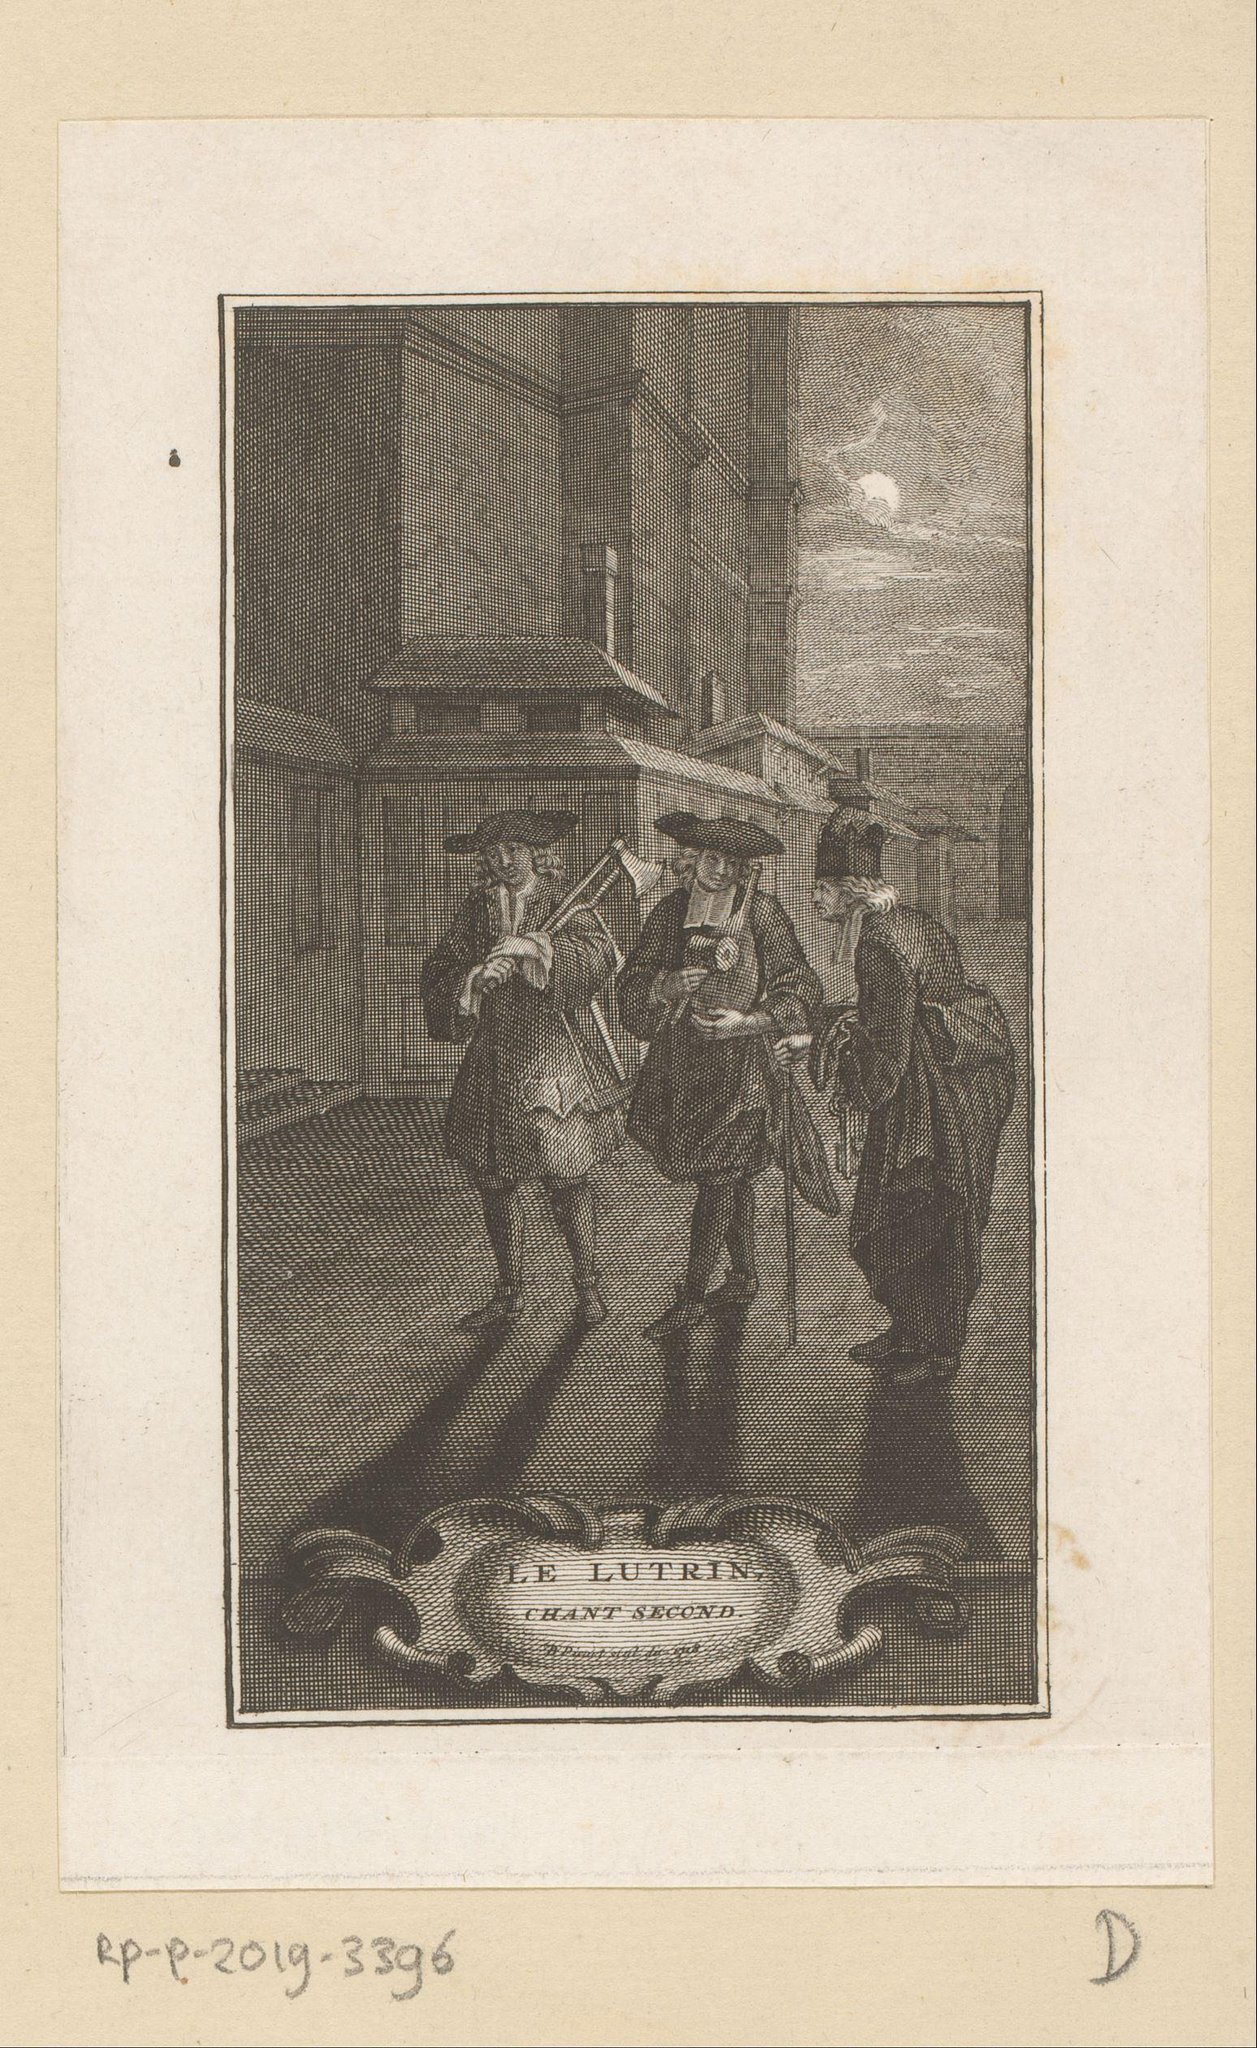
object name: book illustration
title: Drie mannen op straat bij nacht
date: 1718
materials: paper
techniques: engraving, etching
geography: amsterdam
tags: tools, implements of sculptor: mallet, walking-stick, staff, tools, aids, implements ~ crafts and industries: axe, night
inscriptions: collector's mark: Lugt 240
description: Deze prent is de kleine variant van een prent met hetzelfde onderwerp gebruikt in eerdere publicaties. Prent ook gebruikt in: Boileau, Nicolas. Oeuvres de Nicolas Boileau Despréaux. Den Haag: Isaac Vaillant, Pierre Gosse en Pieter de Hondt, 1722, dl. 2.